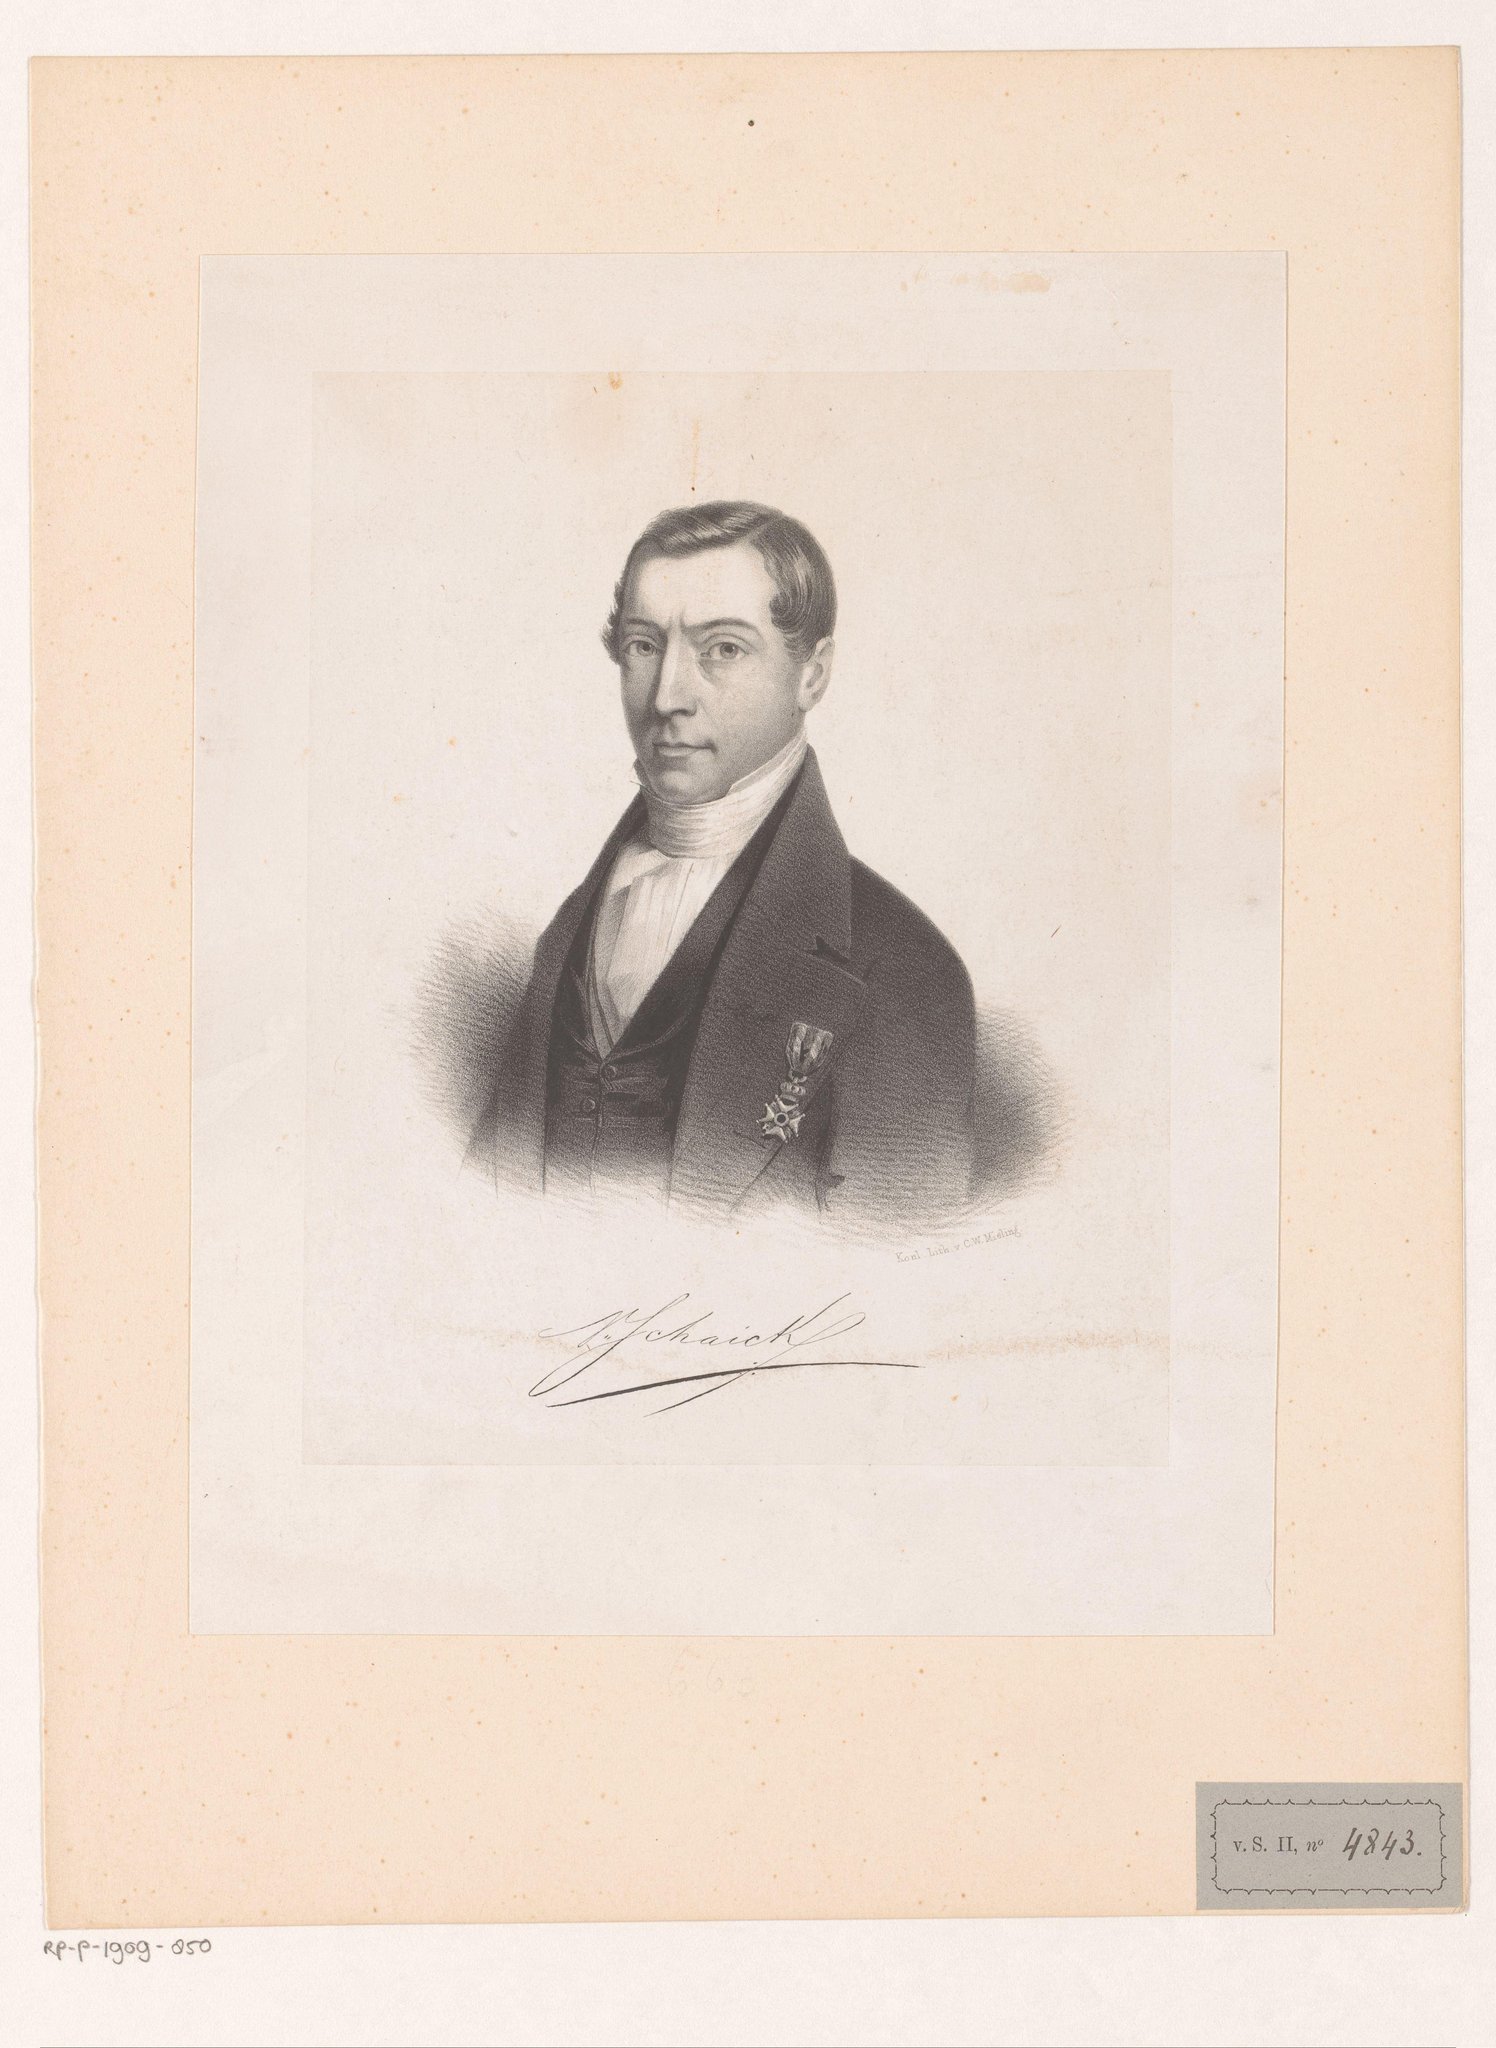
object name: print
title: Portret van Cornelis van Schaick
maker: Anonymous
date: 1847-1865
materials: paper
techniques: lithograph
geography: the hague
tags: amsterdam, knighthood order, historical persons (+ (full) bust portrait)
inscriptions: collector's mark: Lugt 2228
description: Onder het portret de signatuur van de geportretteerde. Op zijn borst draagt hij een ridderorde.